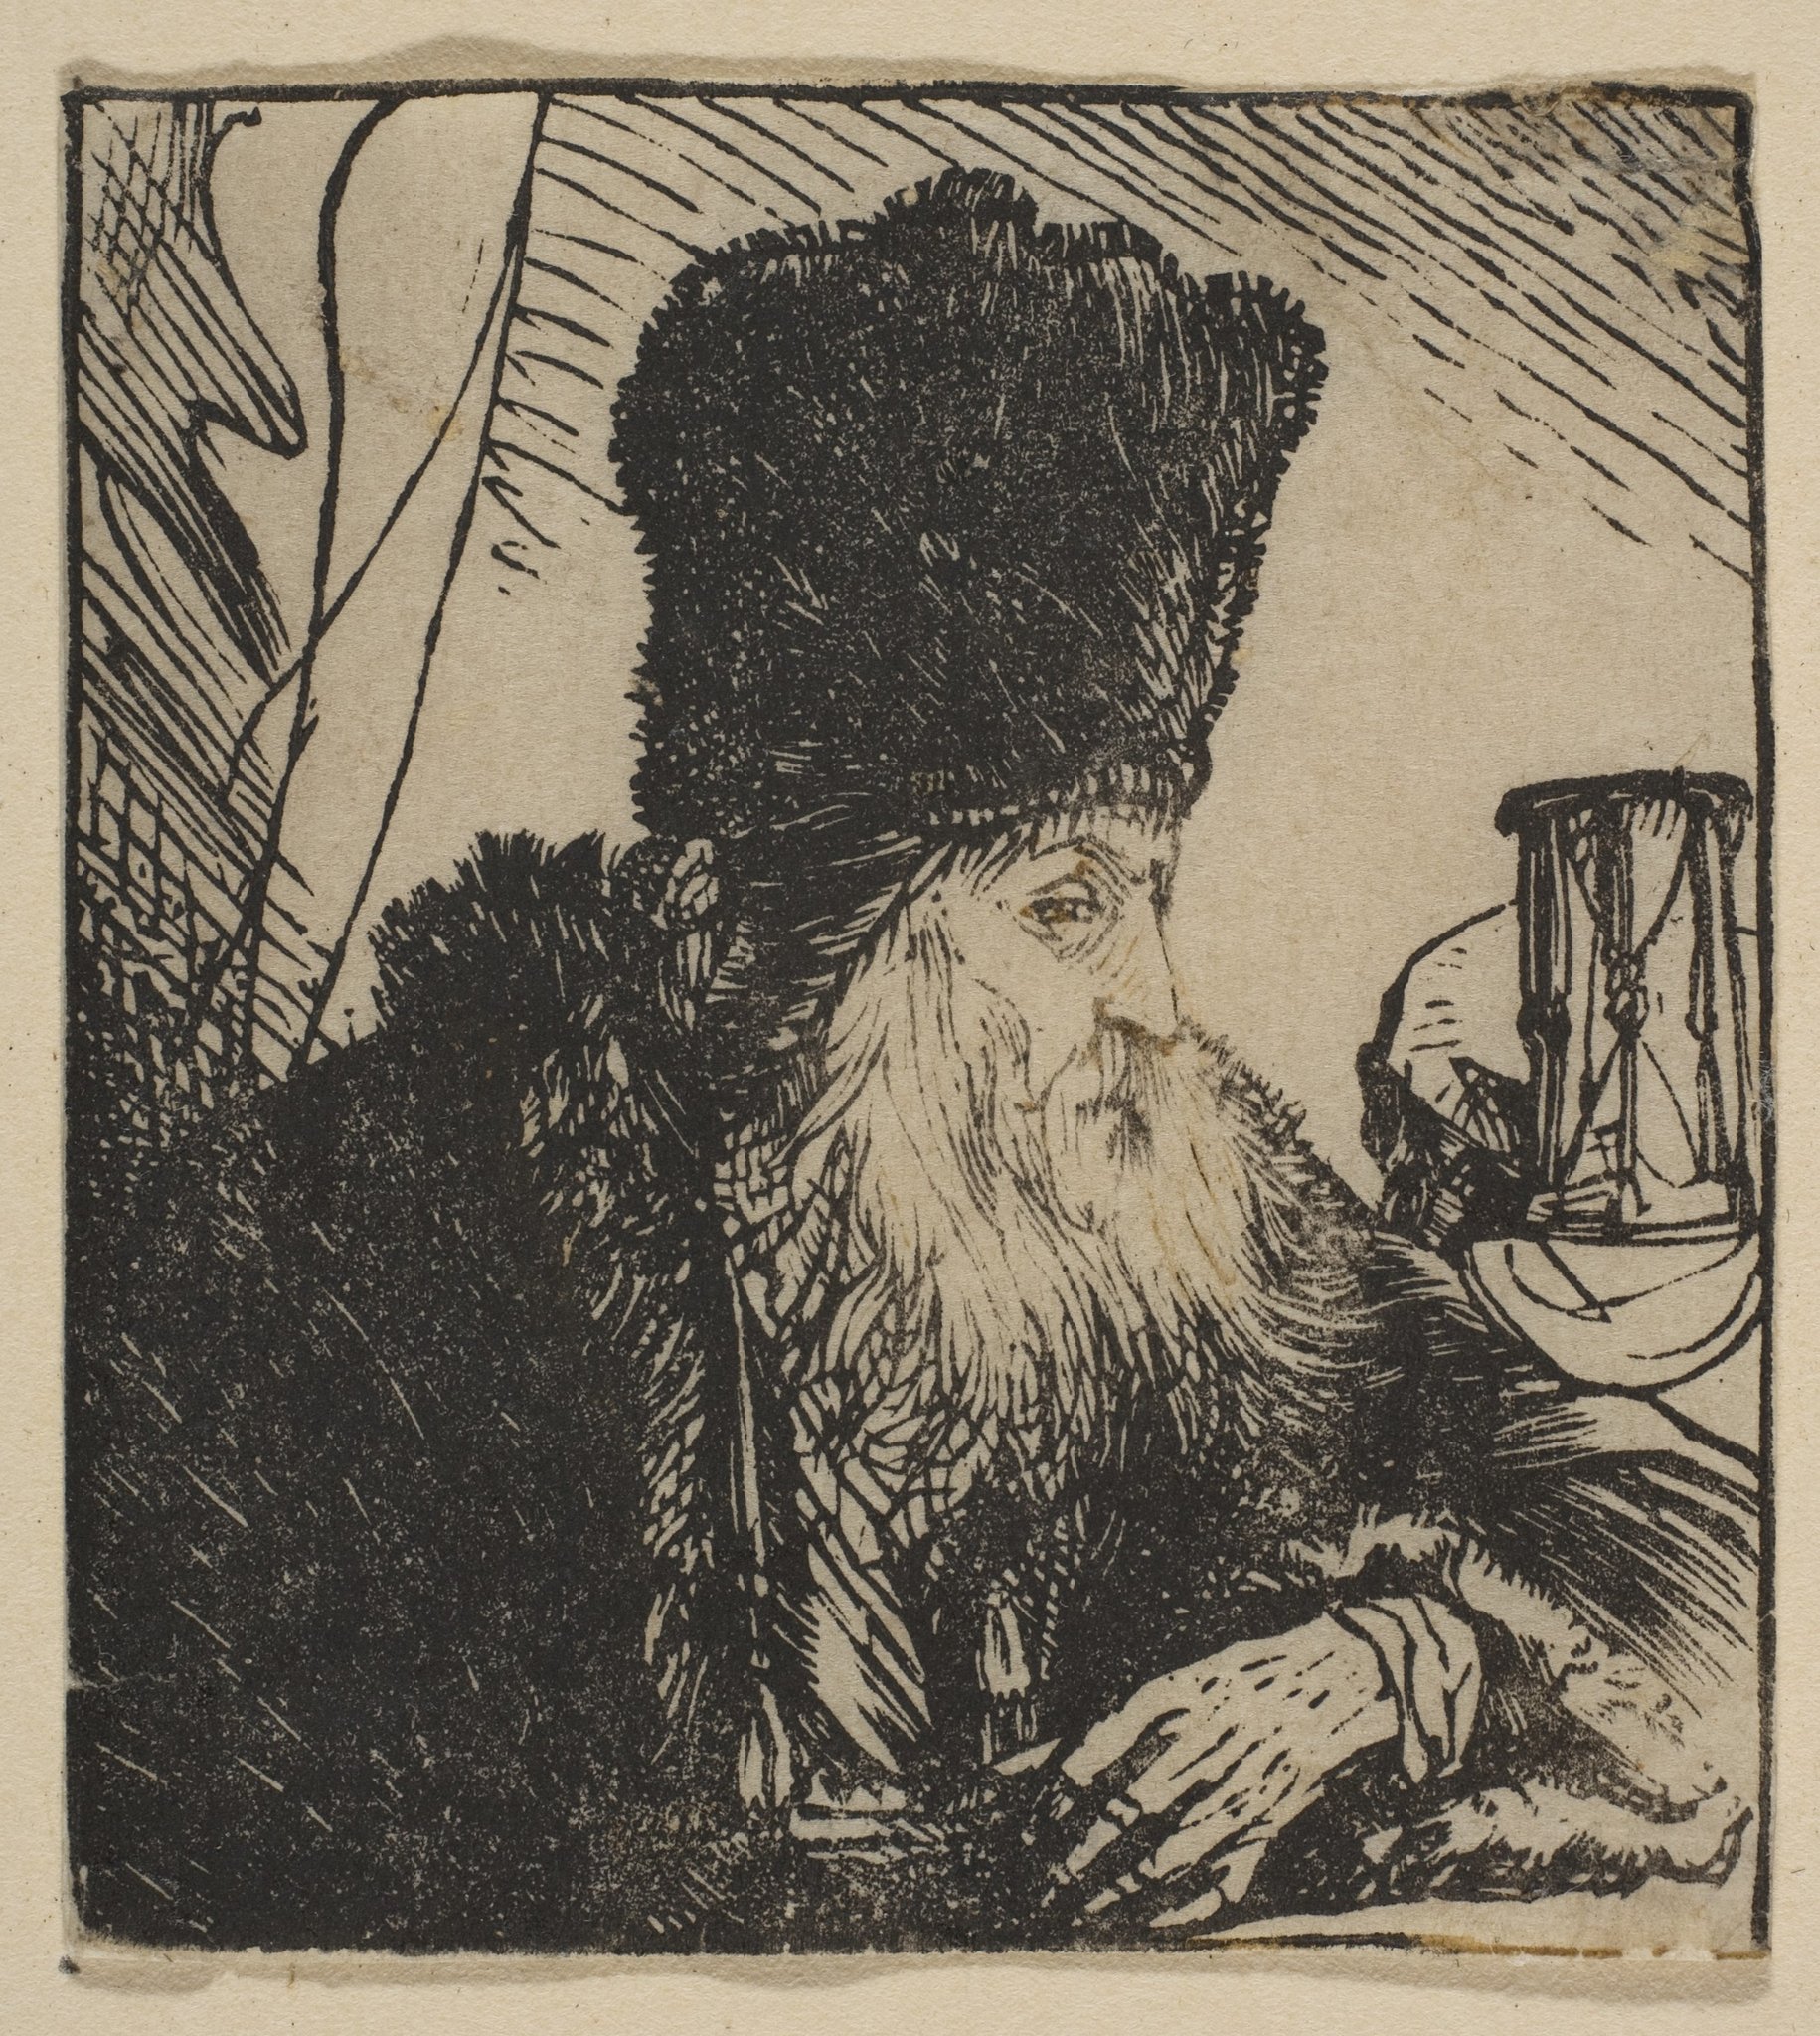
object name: print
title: Philosopher with an Hourglass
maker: jan lievens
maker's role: artist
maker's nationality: dutch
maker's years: 1607-1674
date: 1620-1674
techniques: woodcut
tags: men,profiles,philosophers,hourglass